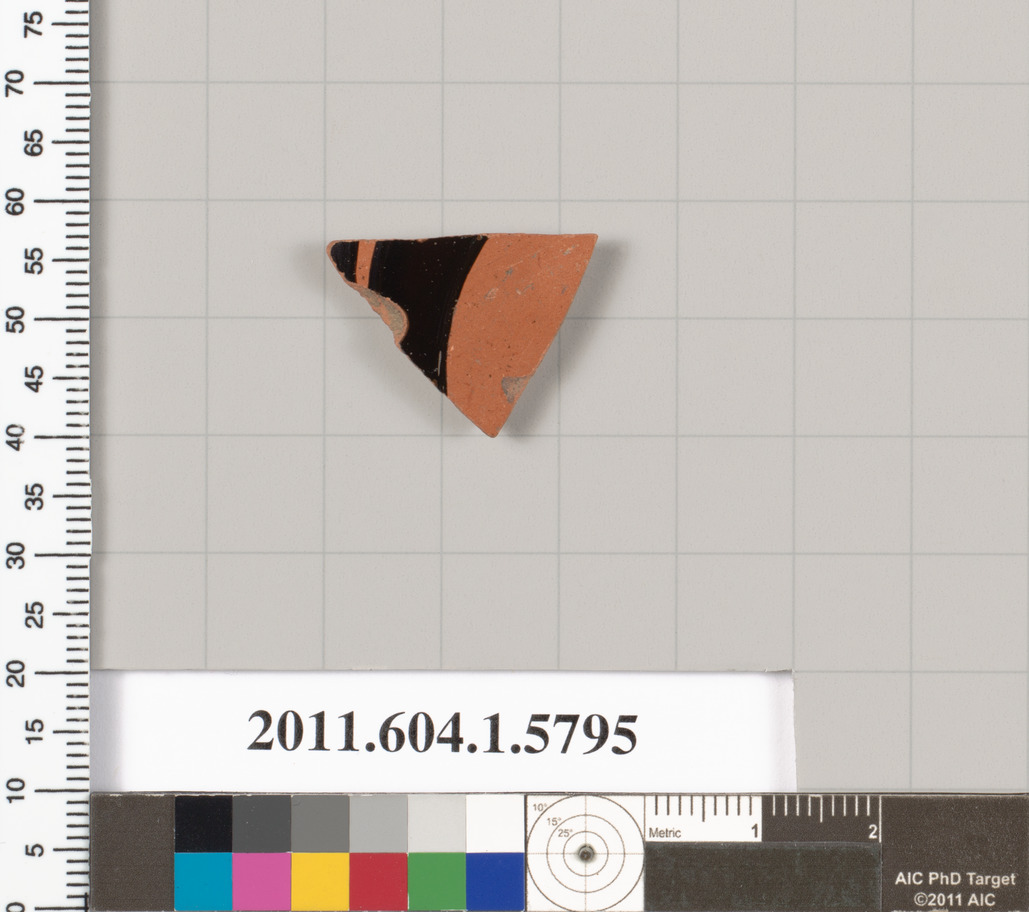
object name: kylix fragment, eye cup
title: Terracotta fragment of a kylix: eye-cup (drinking cup)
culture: greek, attic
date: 520-510 BCE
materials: terracotta